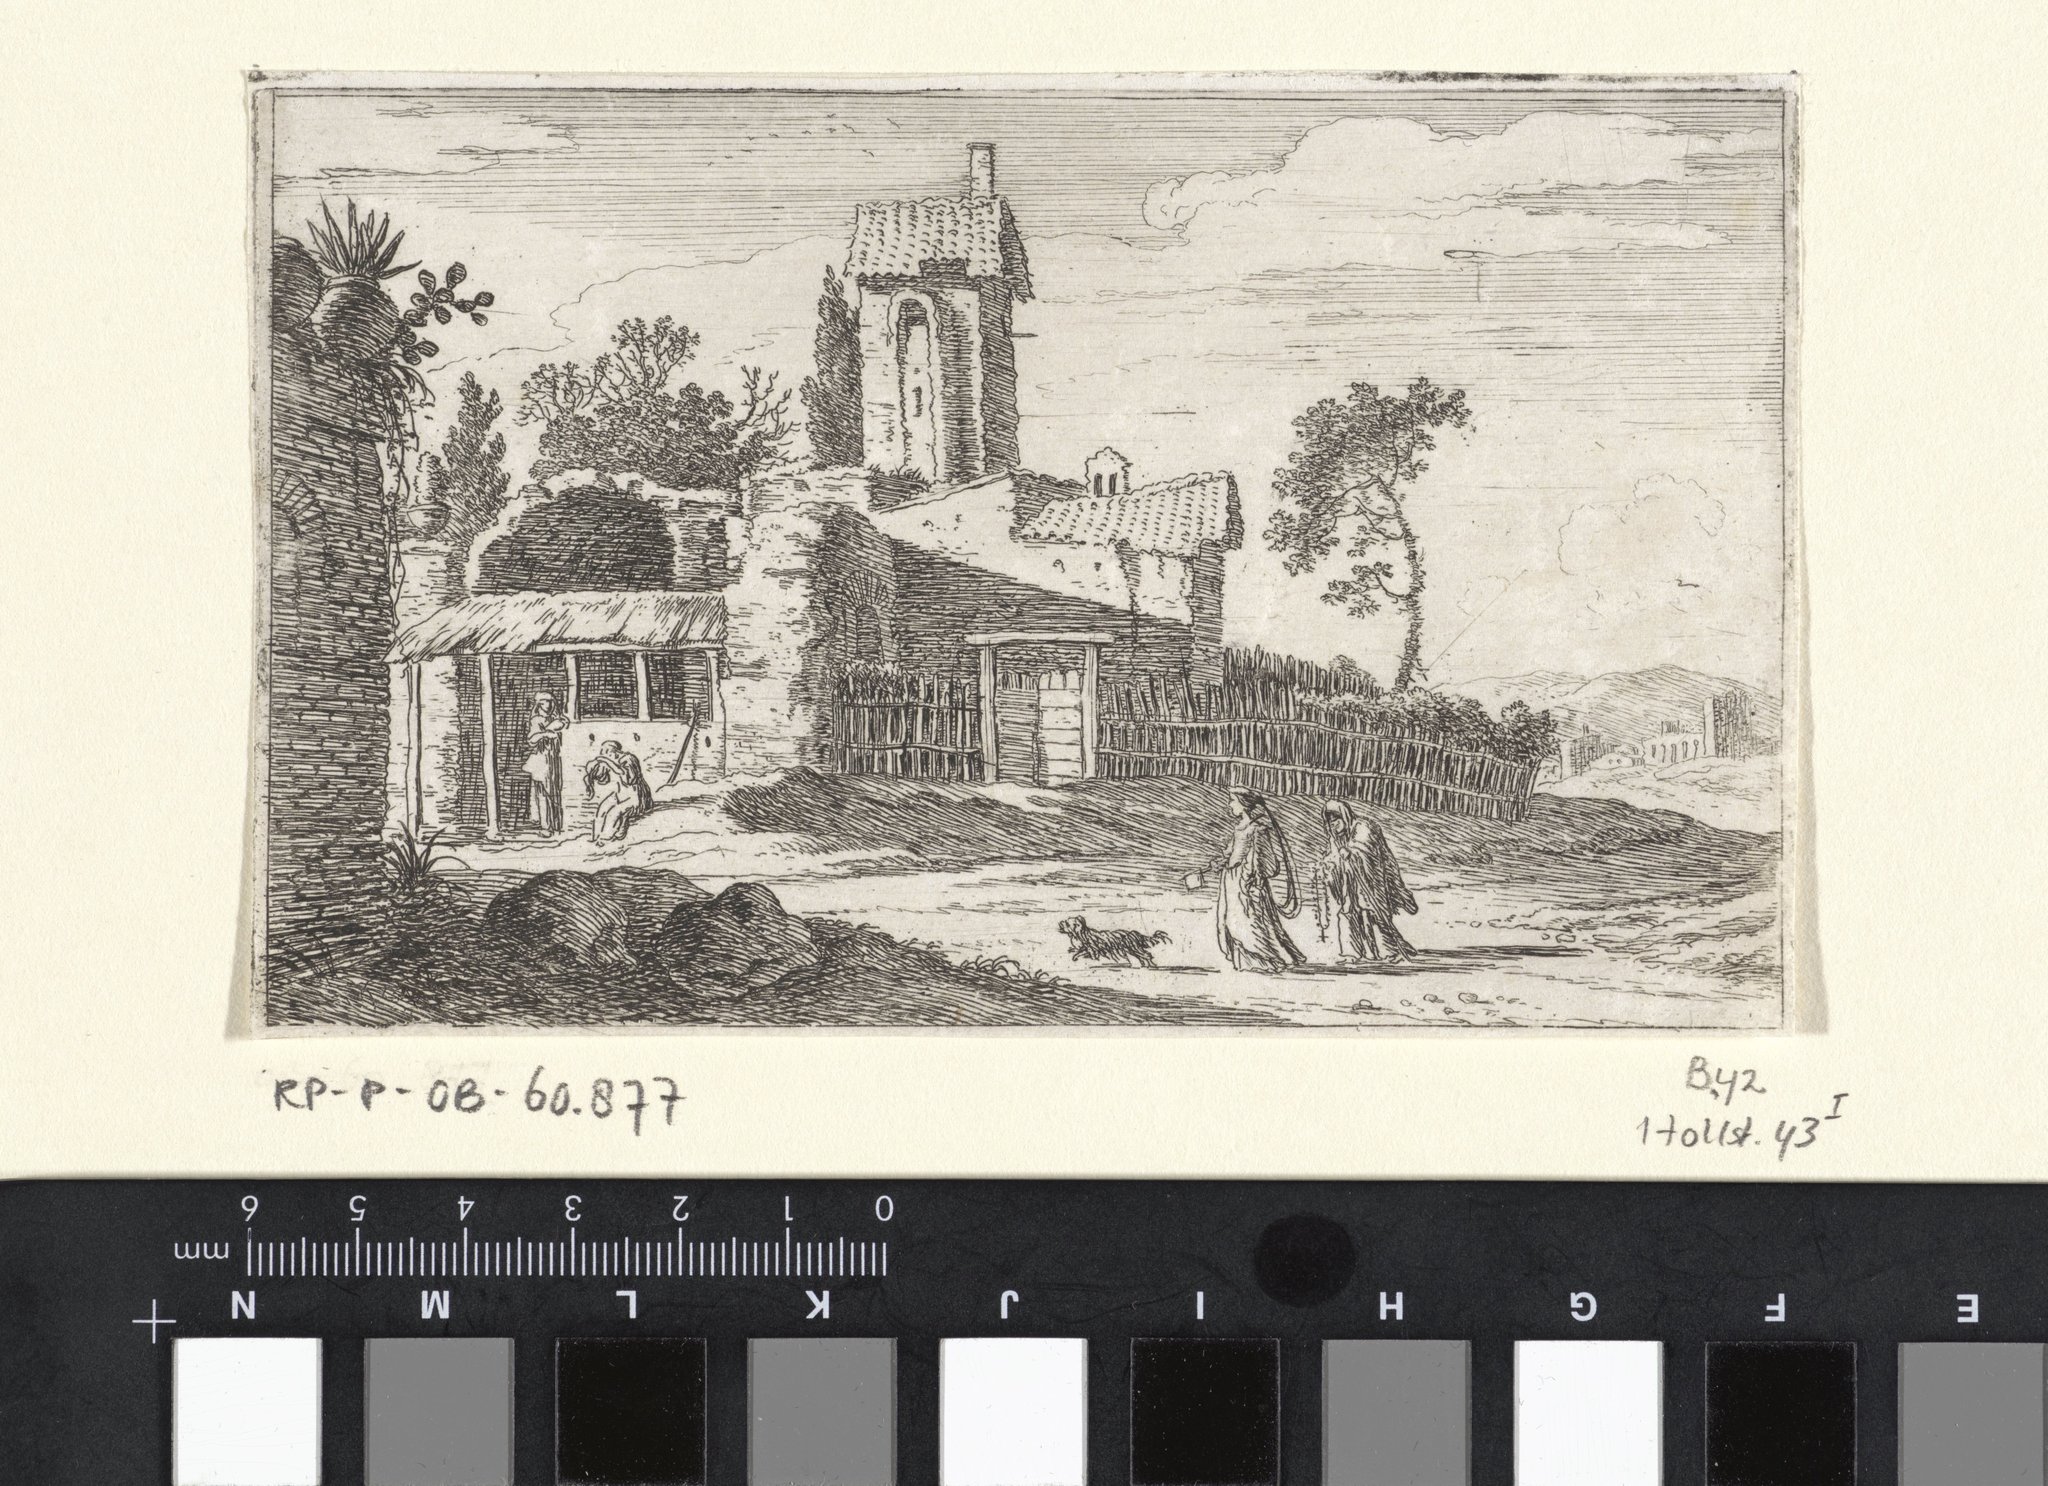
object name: print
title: Titelblad en twaalf gezichten op Rome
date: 1629-1655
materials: paper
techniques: etching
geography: rome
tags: landscapes, animals, farm or solitary house in landscape, dog, country-house, rome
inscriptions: collector's mark: Lugt 240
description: Omheind vervallen gebouw met een toren. Op het pad ervoor lopen twee wandelaars met een hond.